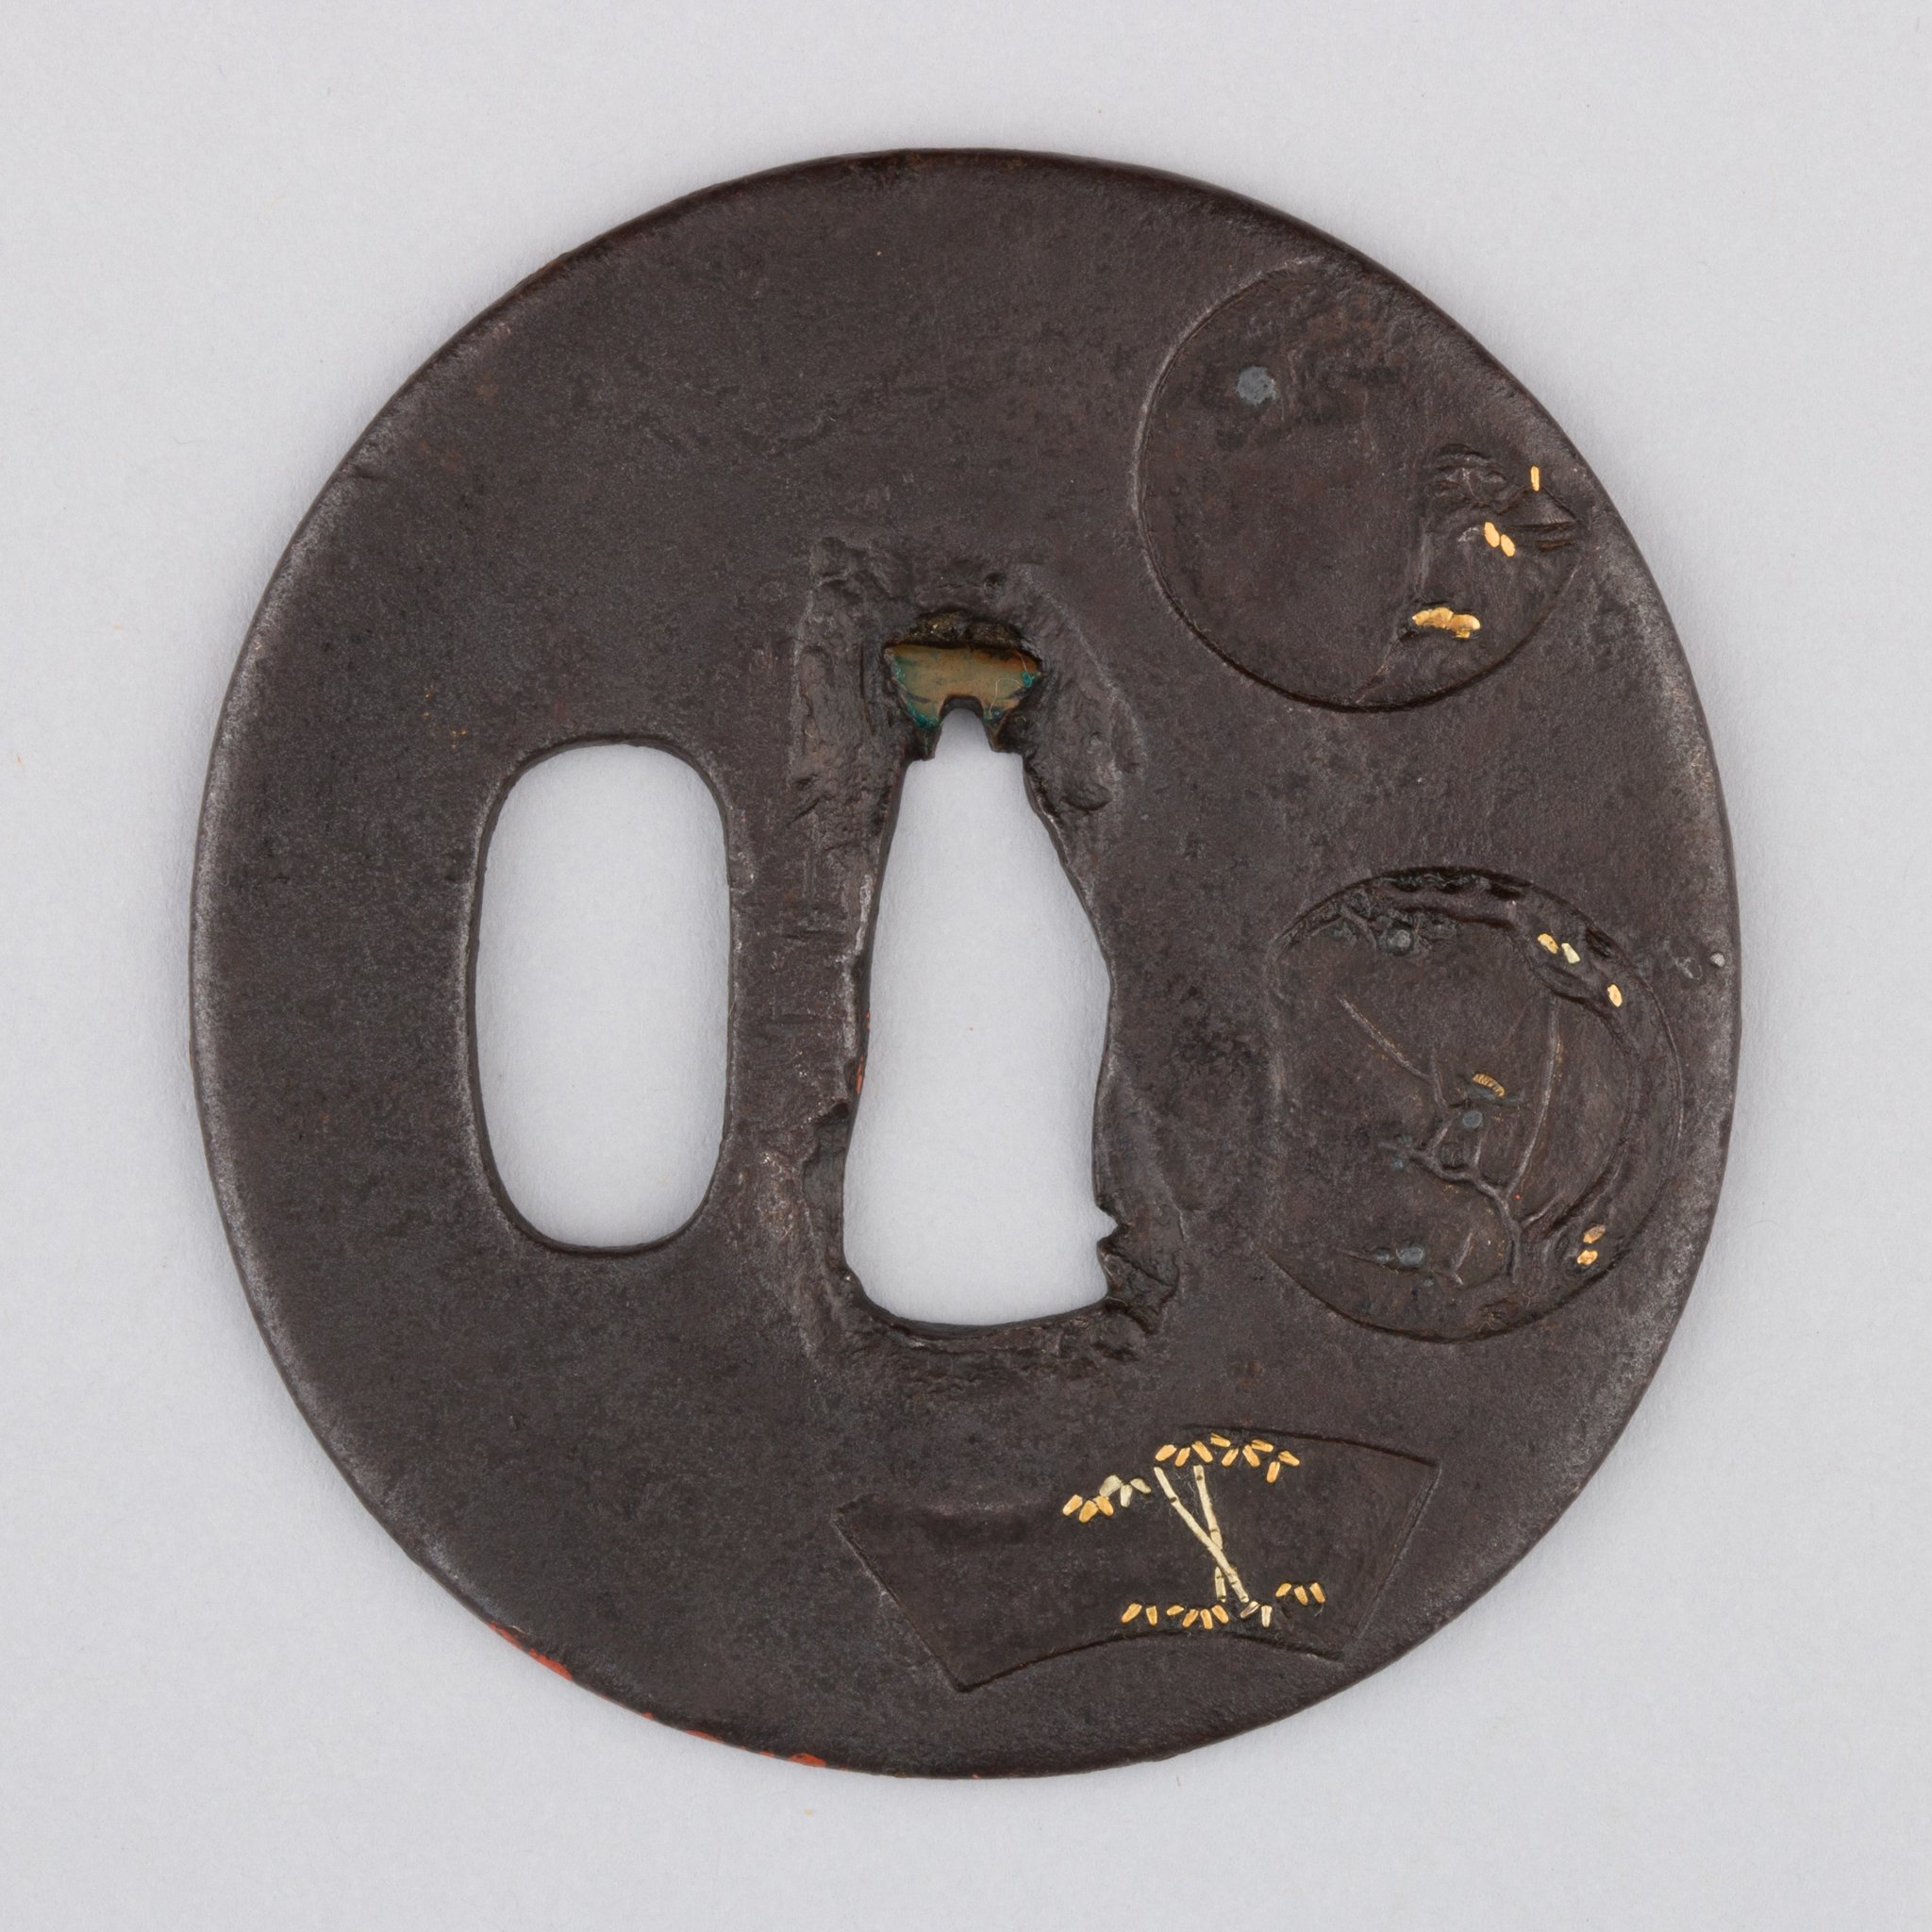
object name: sword guard tsuba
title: Sword Guard (Tsuba)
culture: japanese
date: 1615-1868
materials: copper, iron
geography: japan